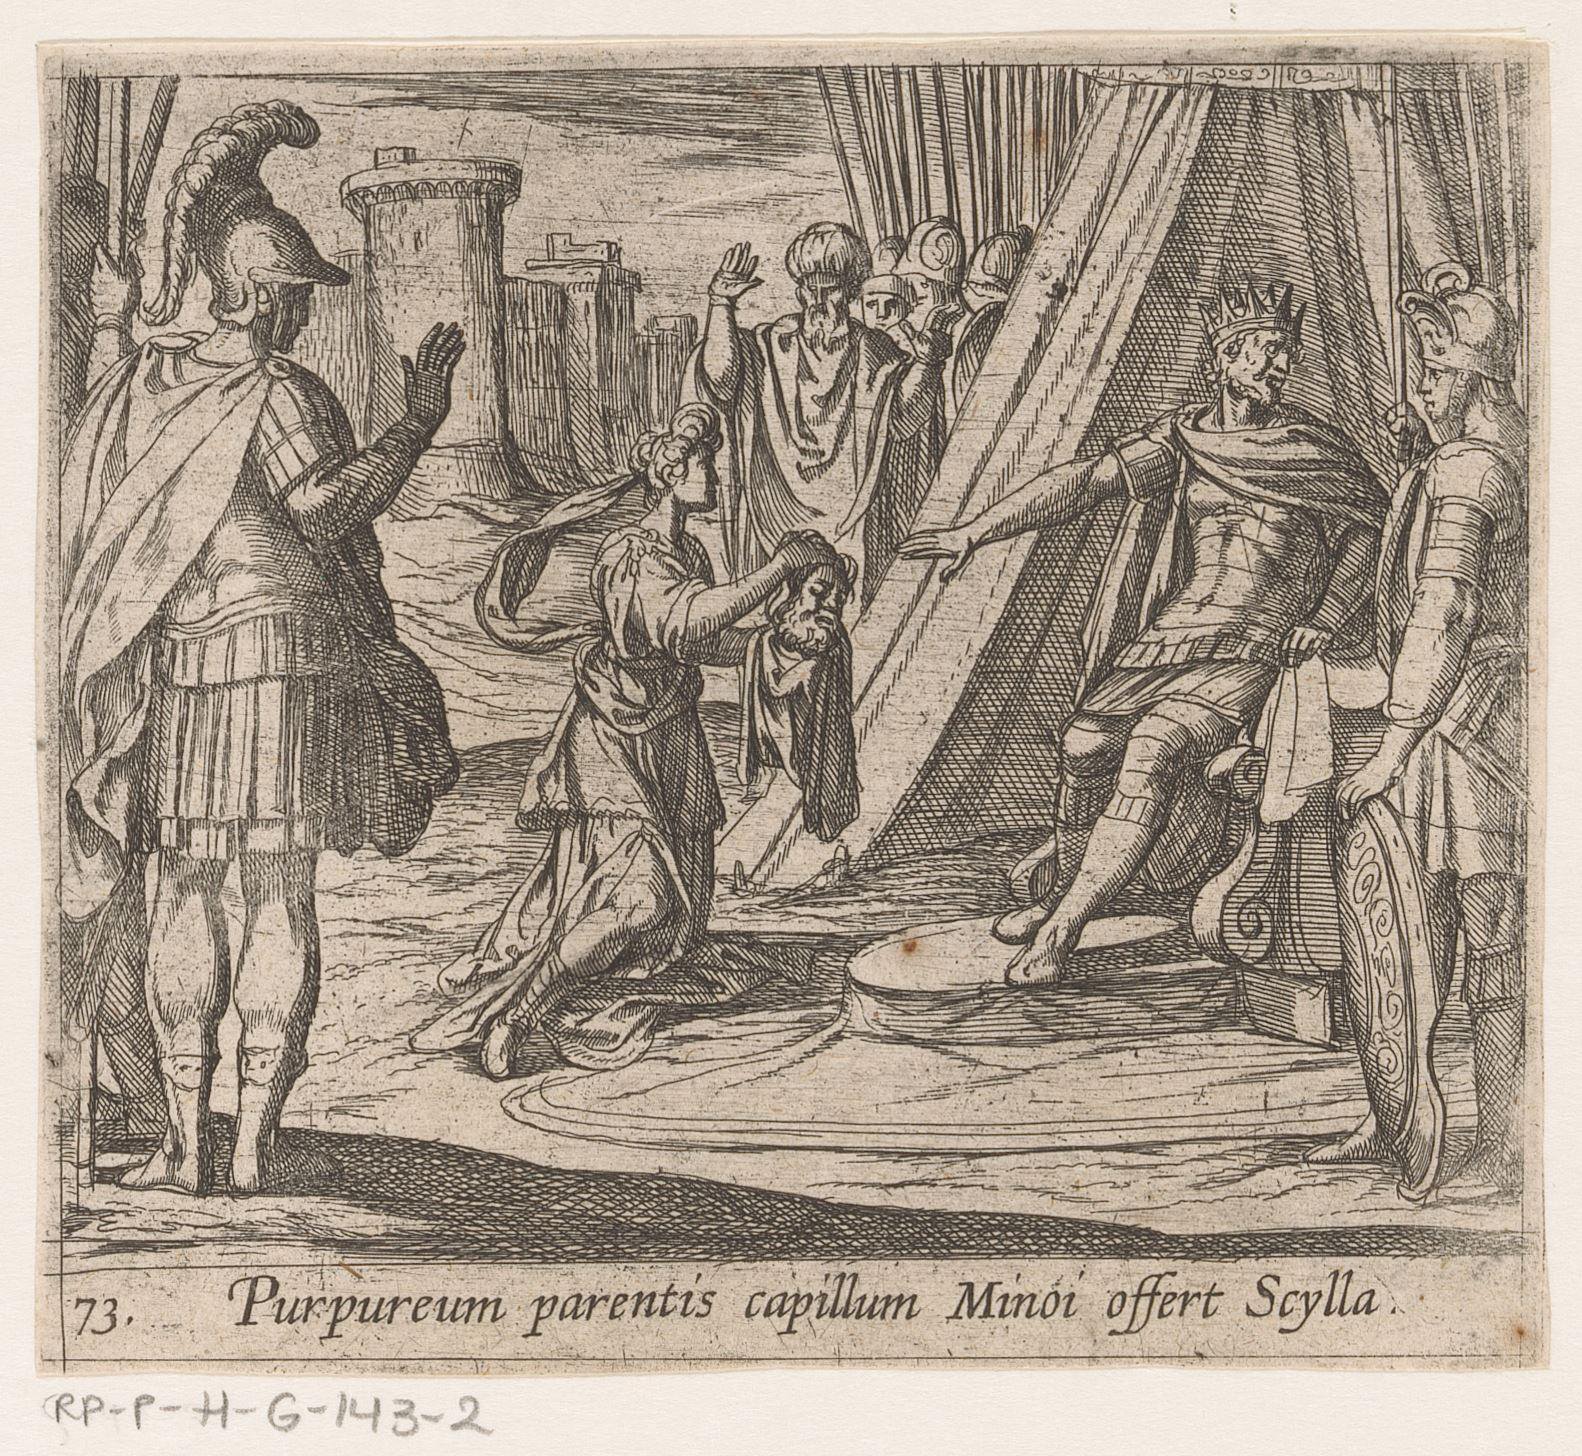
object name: print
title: Metamorfosen van Ovidius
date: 1606-1638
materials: paper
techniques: etching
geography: italy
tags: scylla offers the lock to minos, who rejects her offer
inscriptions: collector's mark: ‘Hinloopen’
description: Deze prent maakt deel uit van een reeks van 150 prenten (+ titelprent) met voorstellingen van de Metamorfosen van Ovidius.